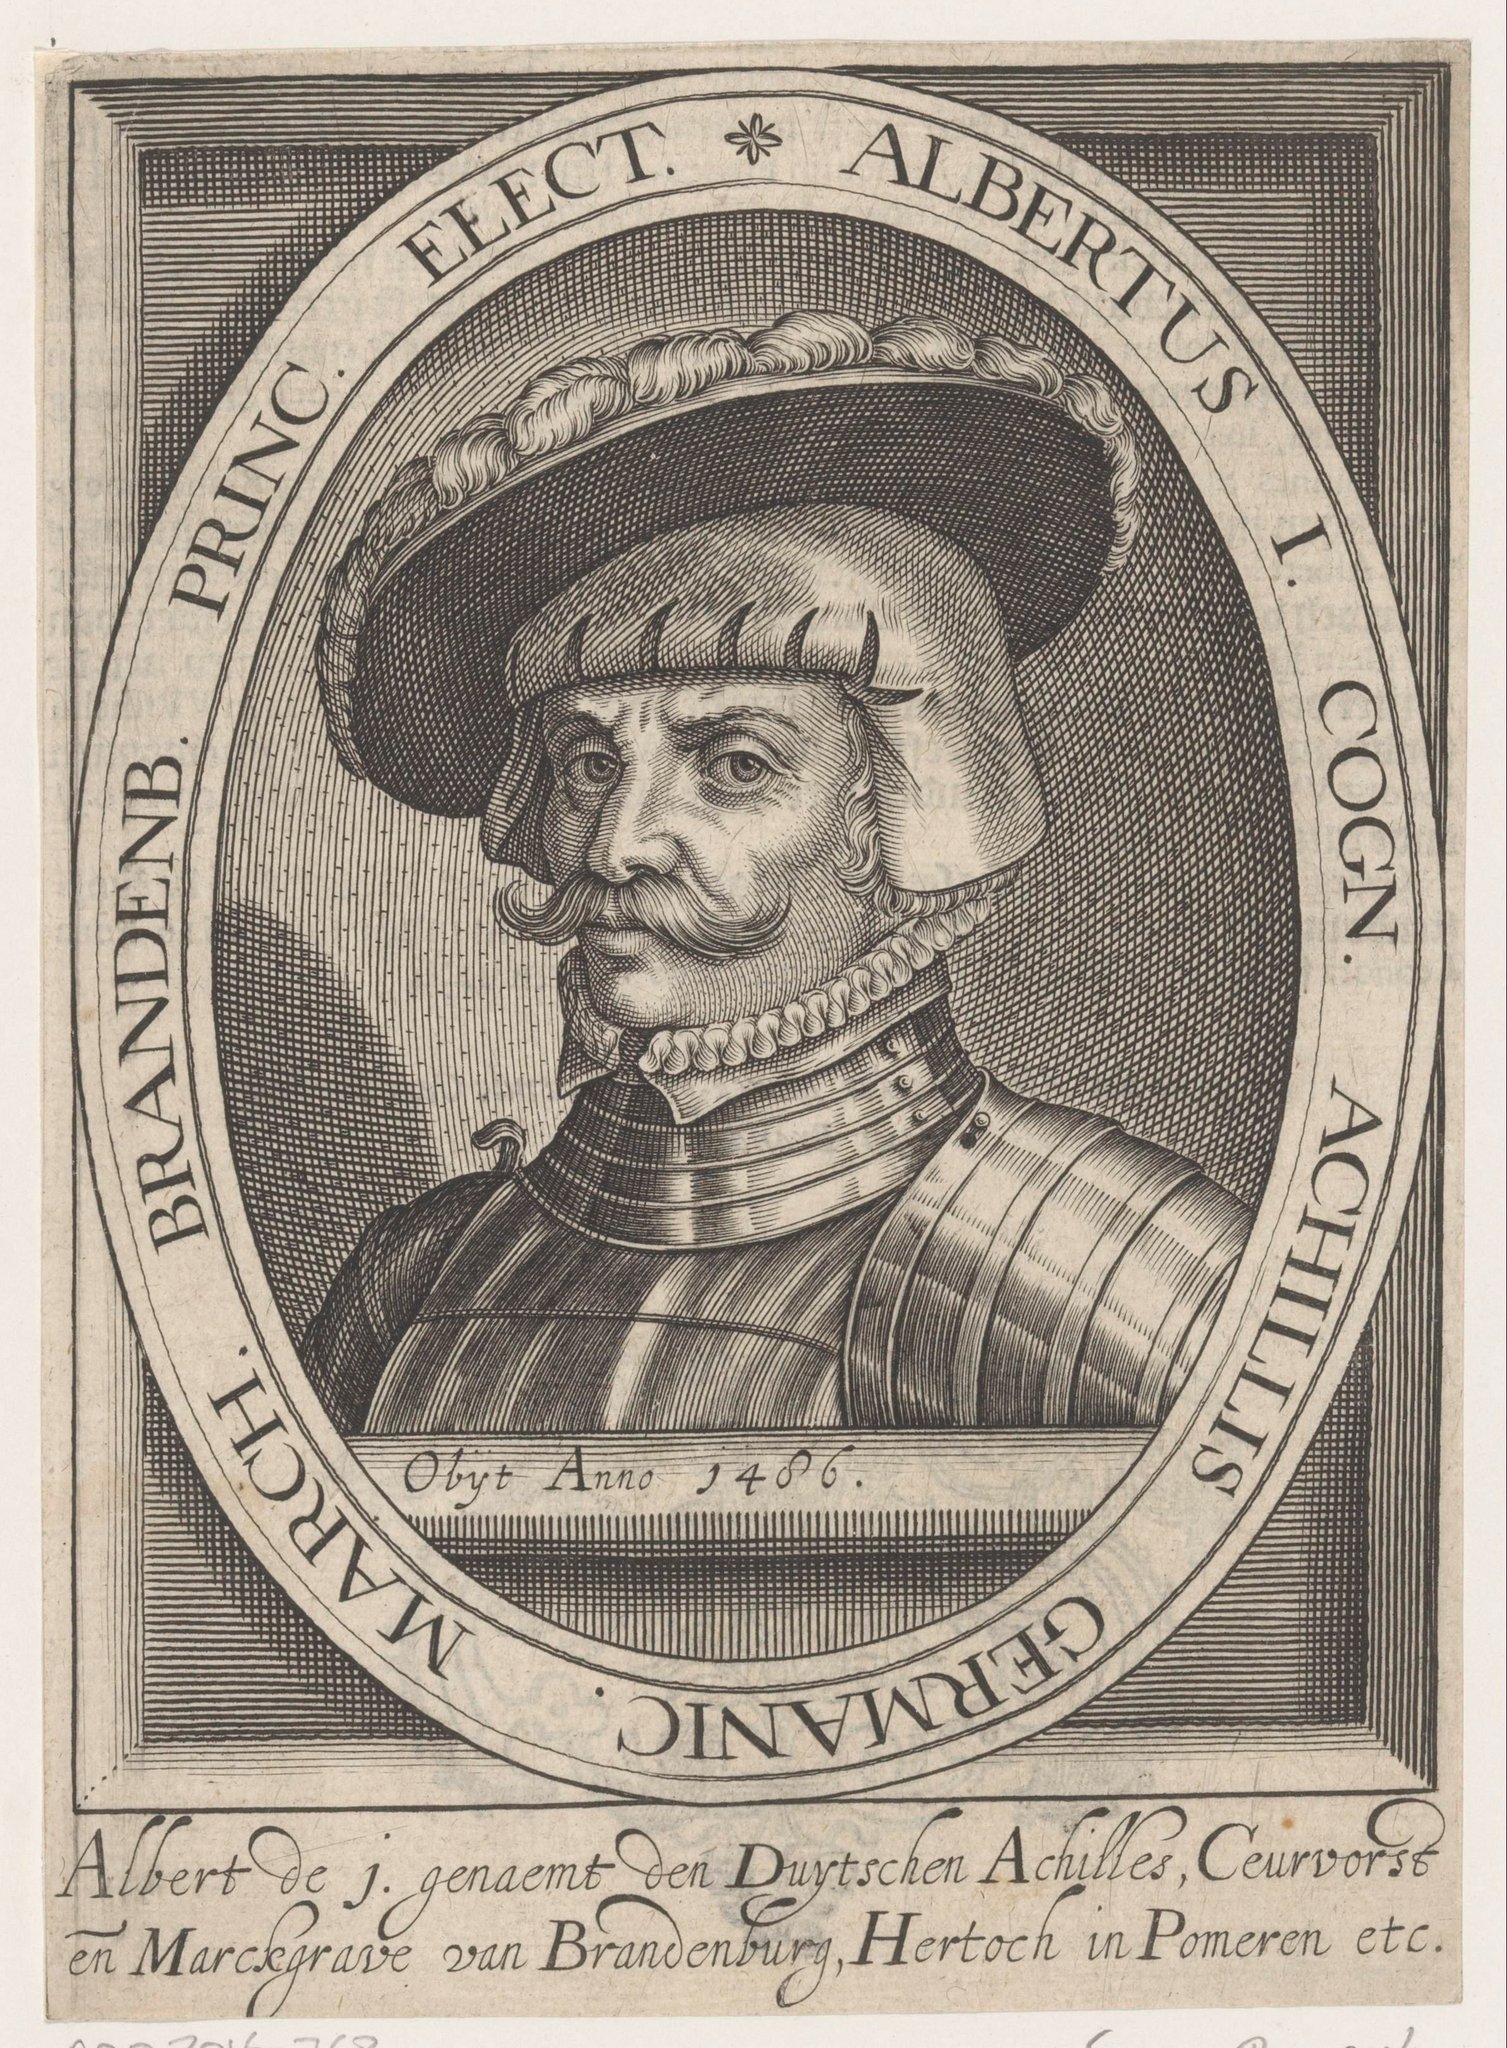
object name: print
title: Portret van Albrecht III Achilles, keurvorst van Brandenburg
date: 1617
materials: paper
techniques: engraving, letterpress printing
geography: delft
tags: keurvorst, albrecht iii achilles keurvorst van brandenburg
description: Prent uit: Clerck, Nicolaes de. Tooneel der beroemder hertogen princen graven ende krygs-helden van christenrijck. Delft: Nicolaes de Clerck, 1617. Dit is waarschijnlijk een portret van Albrecht III Achilles, keurvorst van Brandenburg, en niet van Albrecht I.